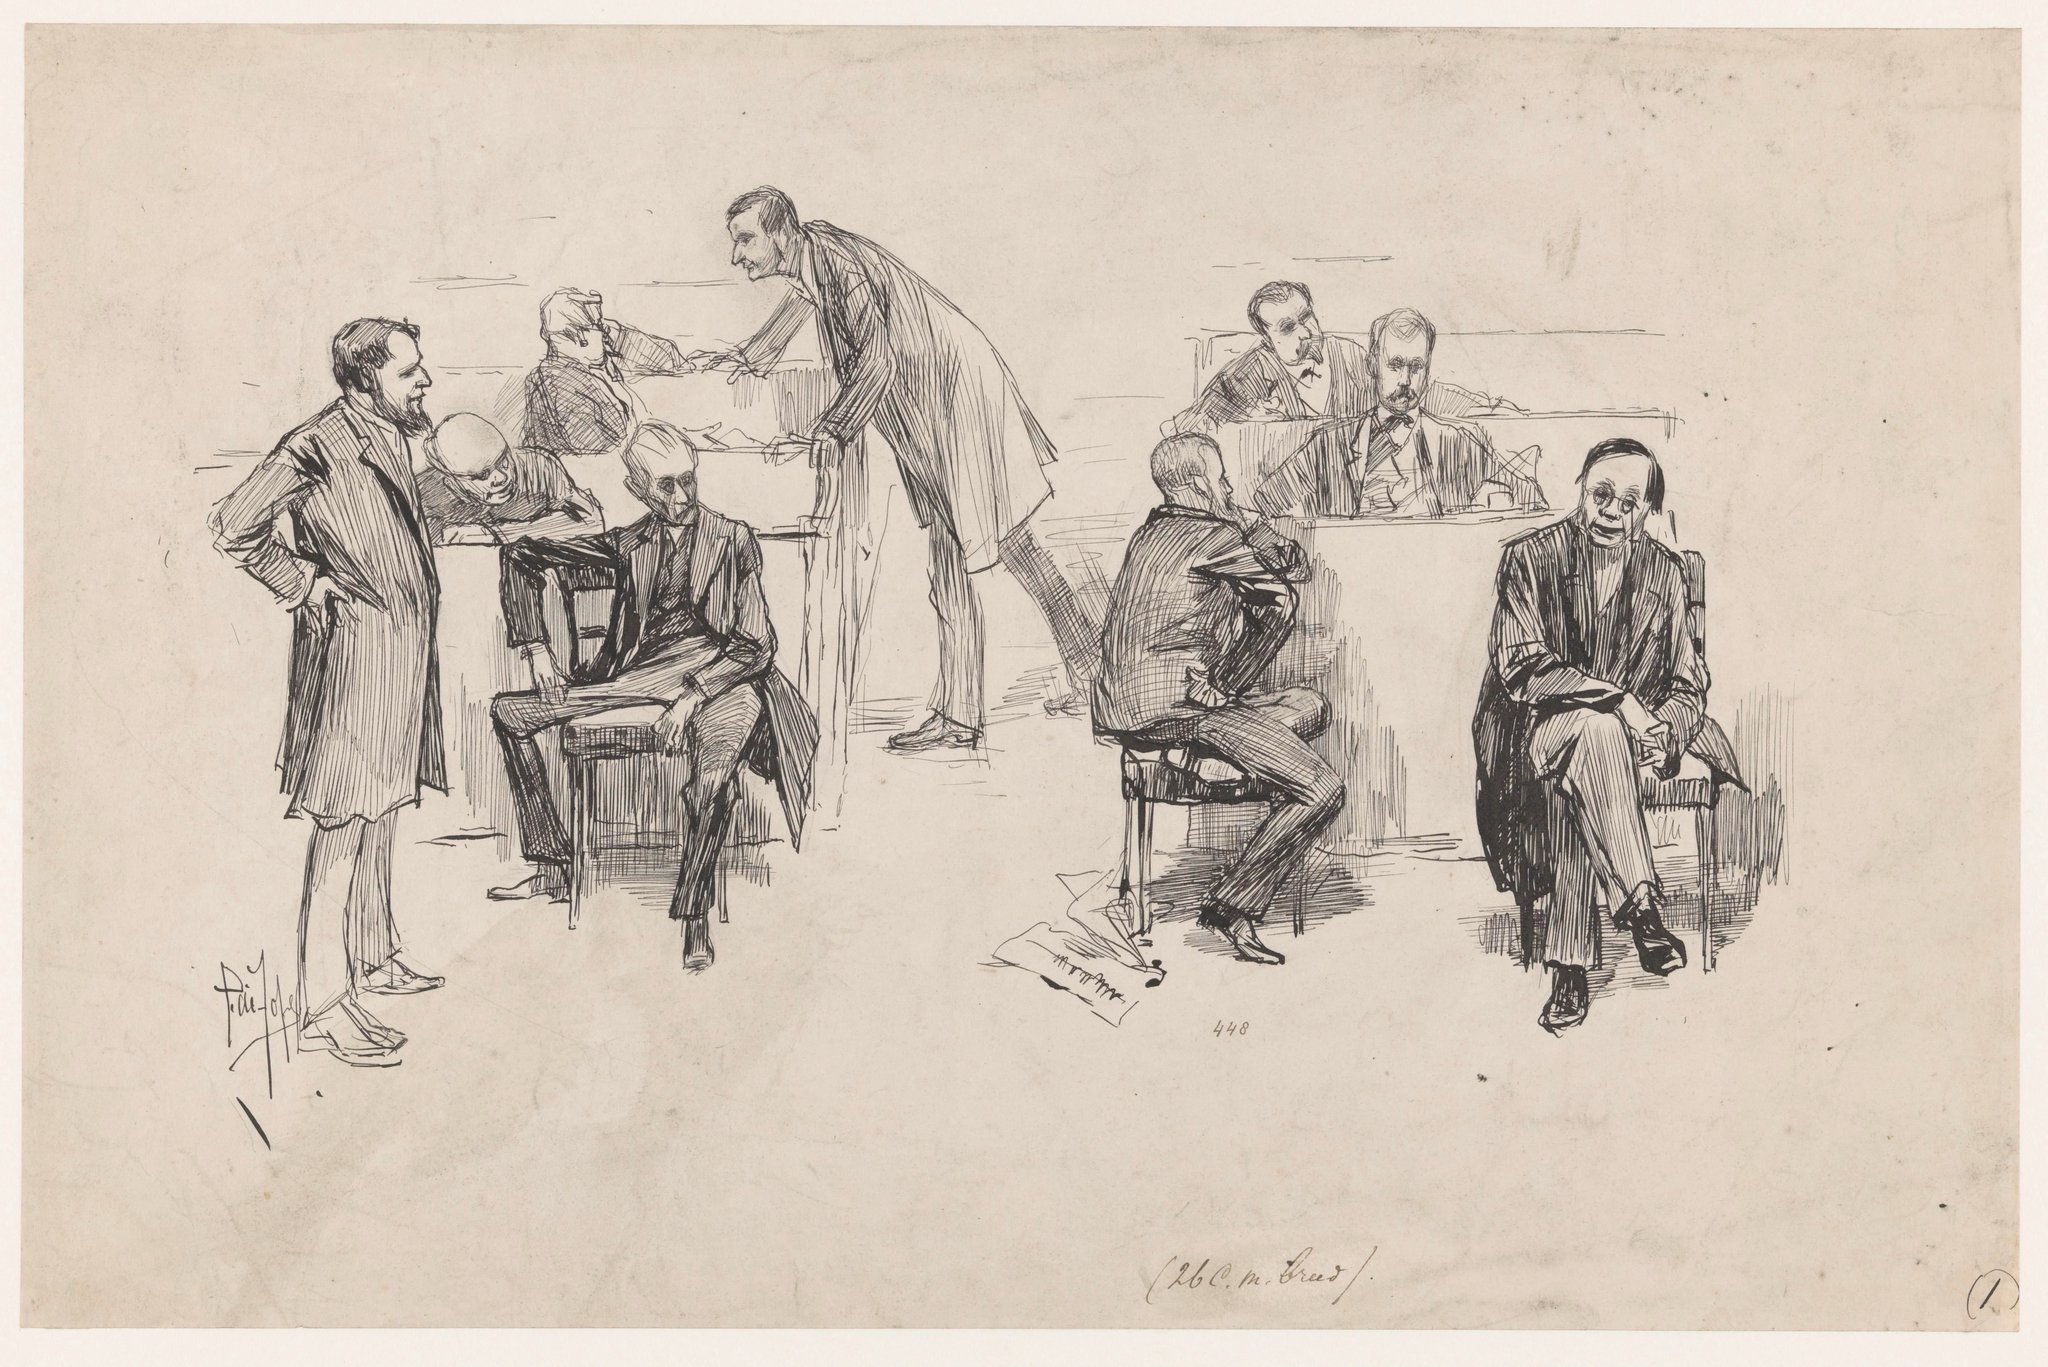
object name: drawing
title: De Tweede Kamer tijdens het debat over de grondwetsherziening in 1887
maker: pieter de josselin de jong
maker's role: draughtsman, painter, print maker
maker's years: 1861-1906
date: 1887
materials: paper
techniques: pen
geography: the hague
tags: jonkheer alexander frederik de savornin lohman, rome, priest, herman johannes aloysius maria schaepman, nijmegen, the hague, rotterdam, bergen op zoom, batavia, lower house, parliament, chamber, netherlands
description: Kamerleden aan de rechterzijde van de vergaderzaal van de Tweede Kamer tijdens het debat. Negen heren in rokkostuum in en voor kamerbanken. Voorgesteld zijn van links naar rechts de kamerleden Beelaerts van Blokland, Schaepman, Van der Schriek, Keuchenius, De Savornin Lohman, Godin de Beaufort, Bahlmann, Mackay en Smeele. Onderdeel van een groep schetsen van de bespreking in de Tweede Kamer van de grondwetsherziening van 1887, deels gepubliceerd in het weekblad Eigen Haard (1887).